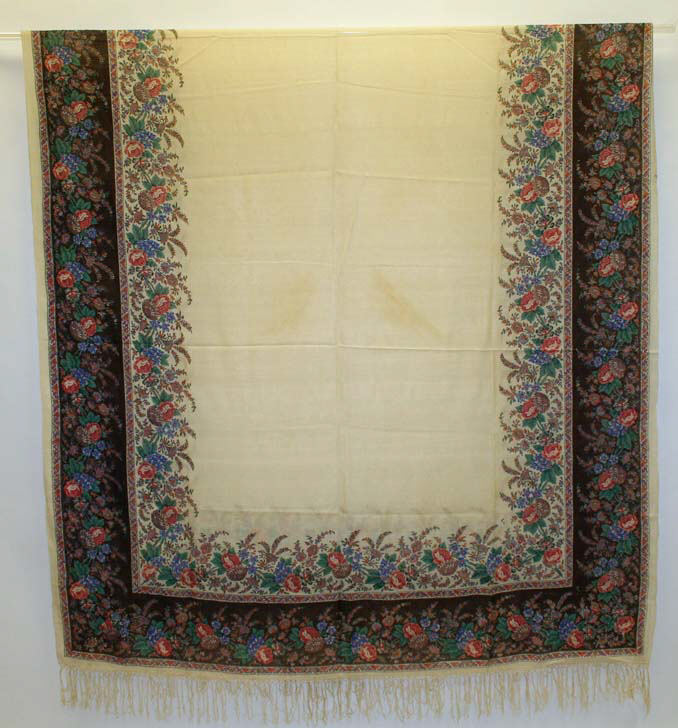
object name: shawl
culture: french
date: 1830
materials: silk, wool